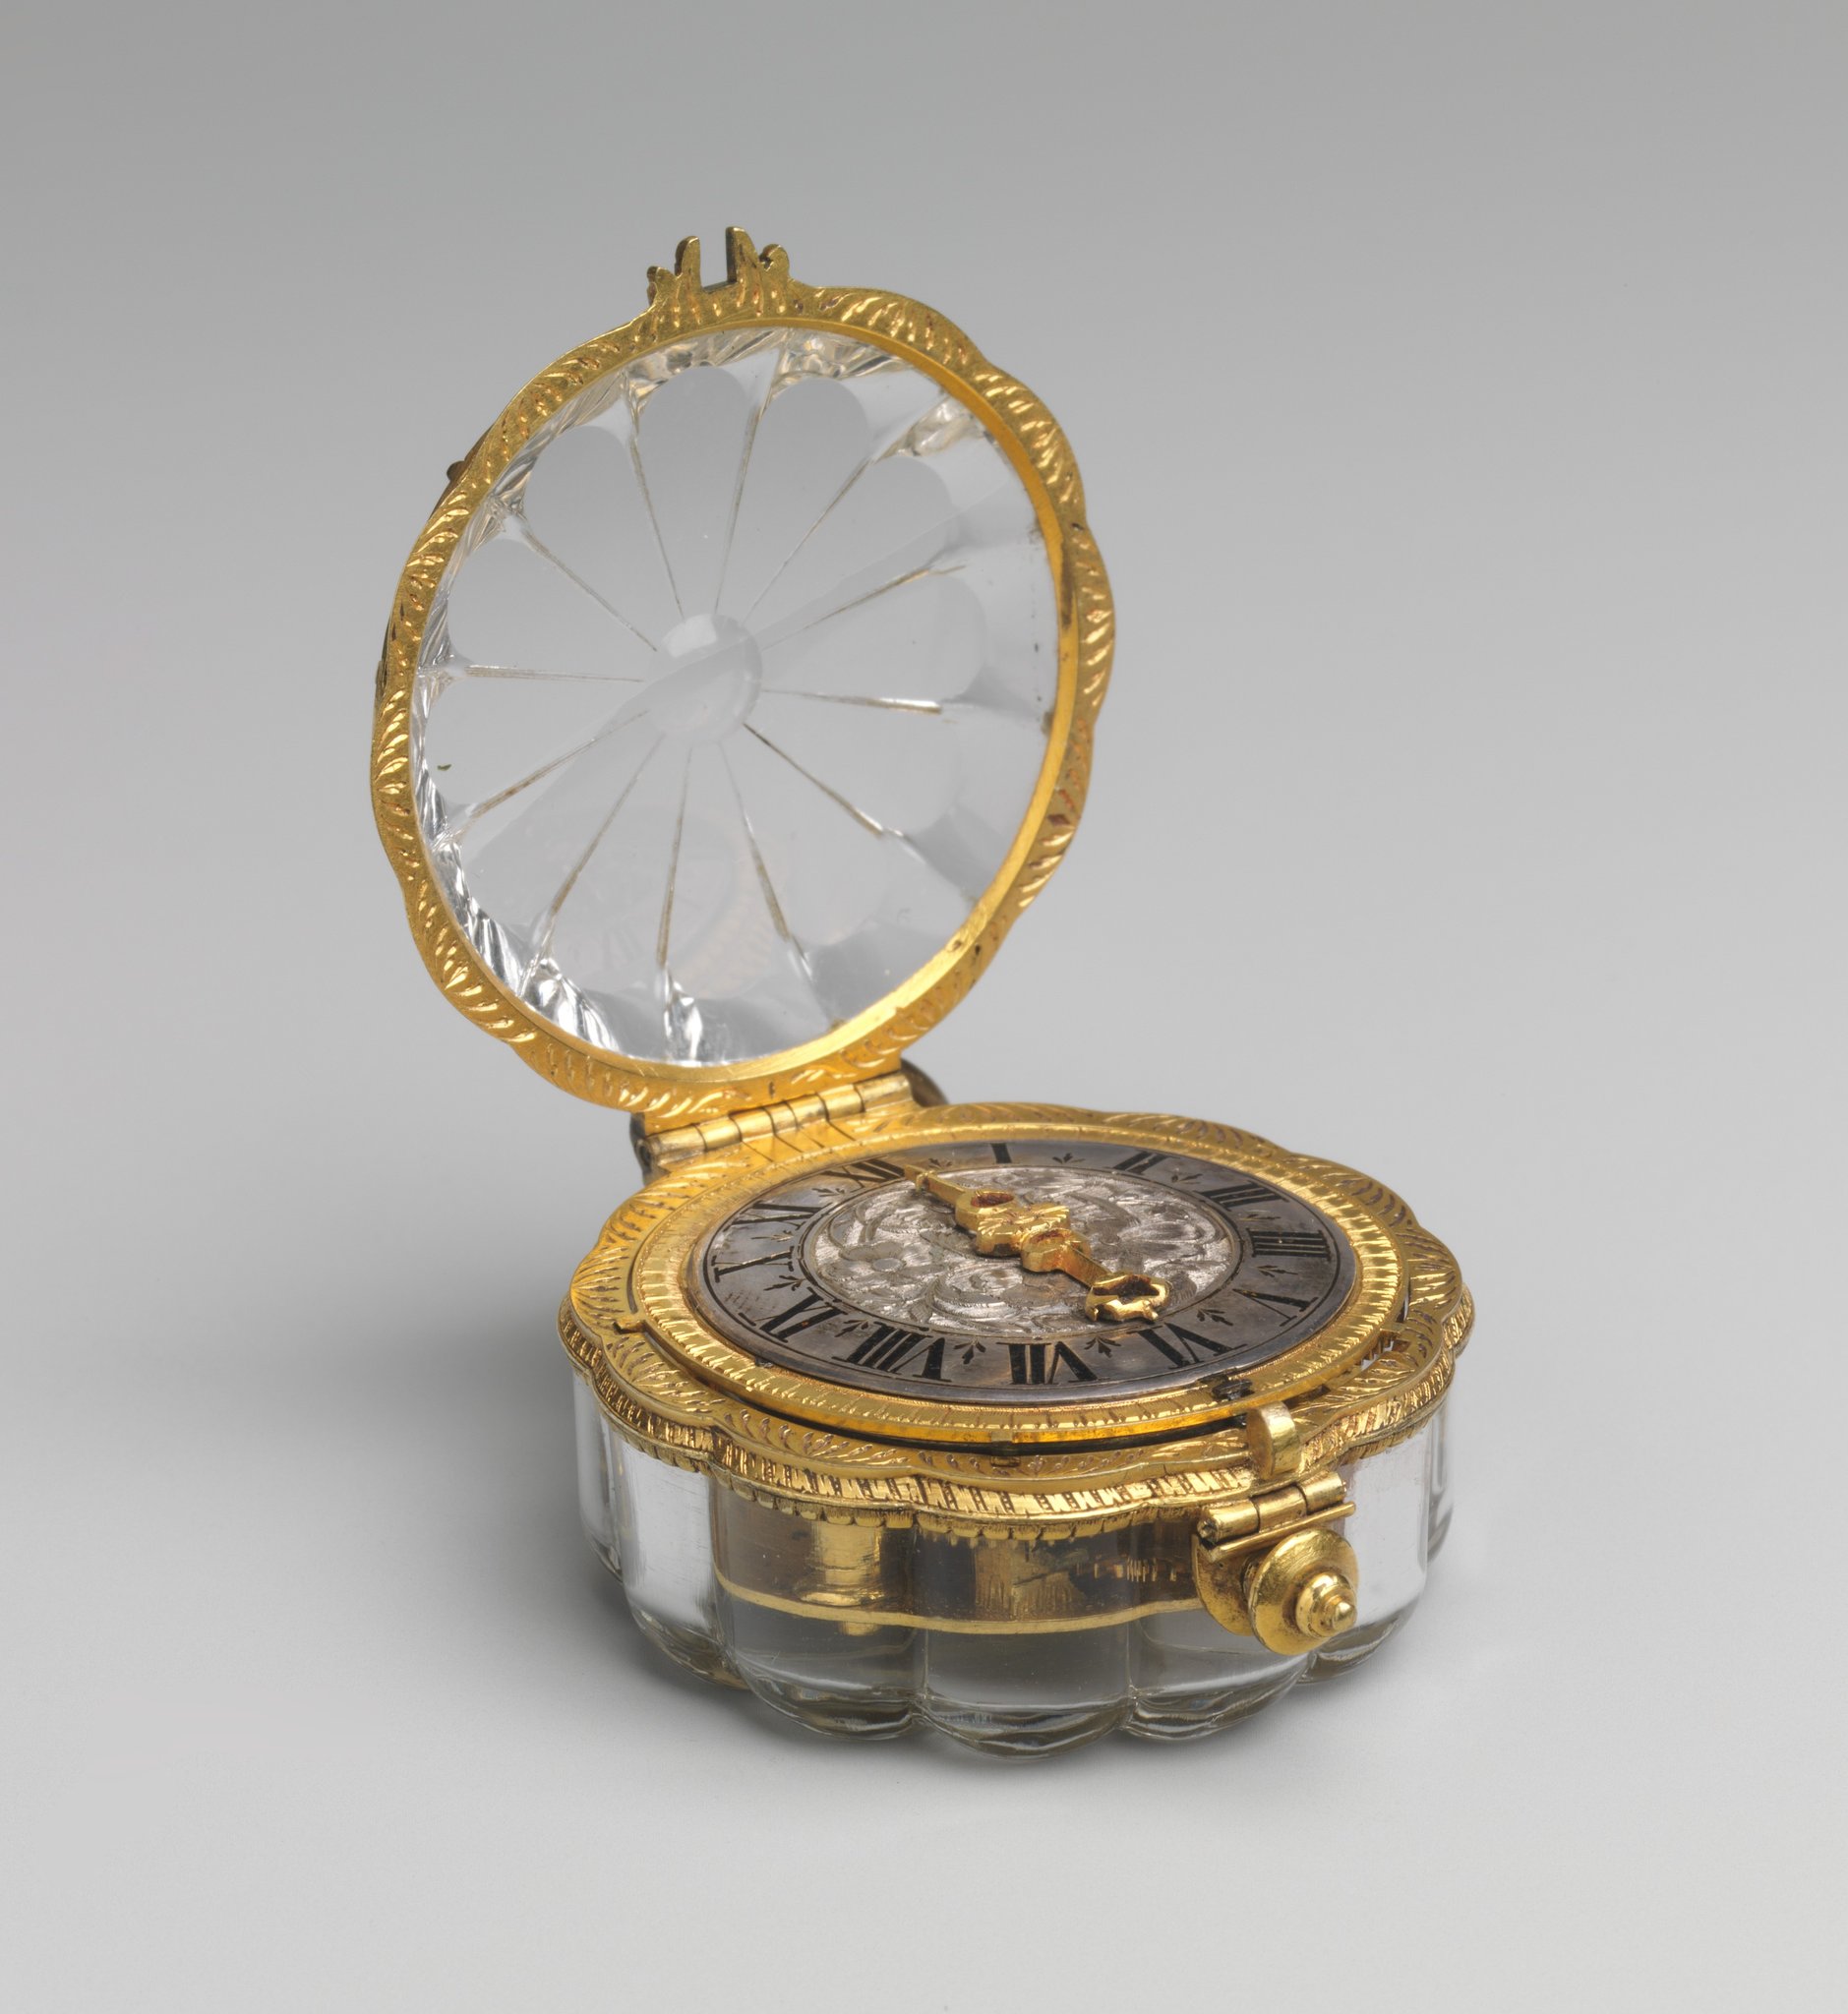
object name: watch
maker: jean rousseau the younger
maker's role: maker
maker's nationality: swiss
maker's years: 1606-1684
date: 1650-1660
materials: enamel, gilt brass, quartz, silver, steel